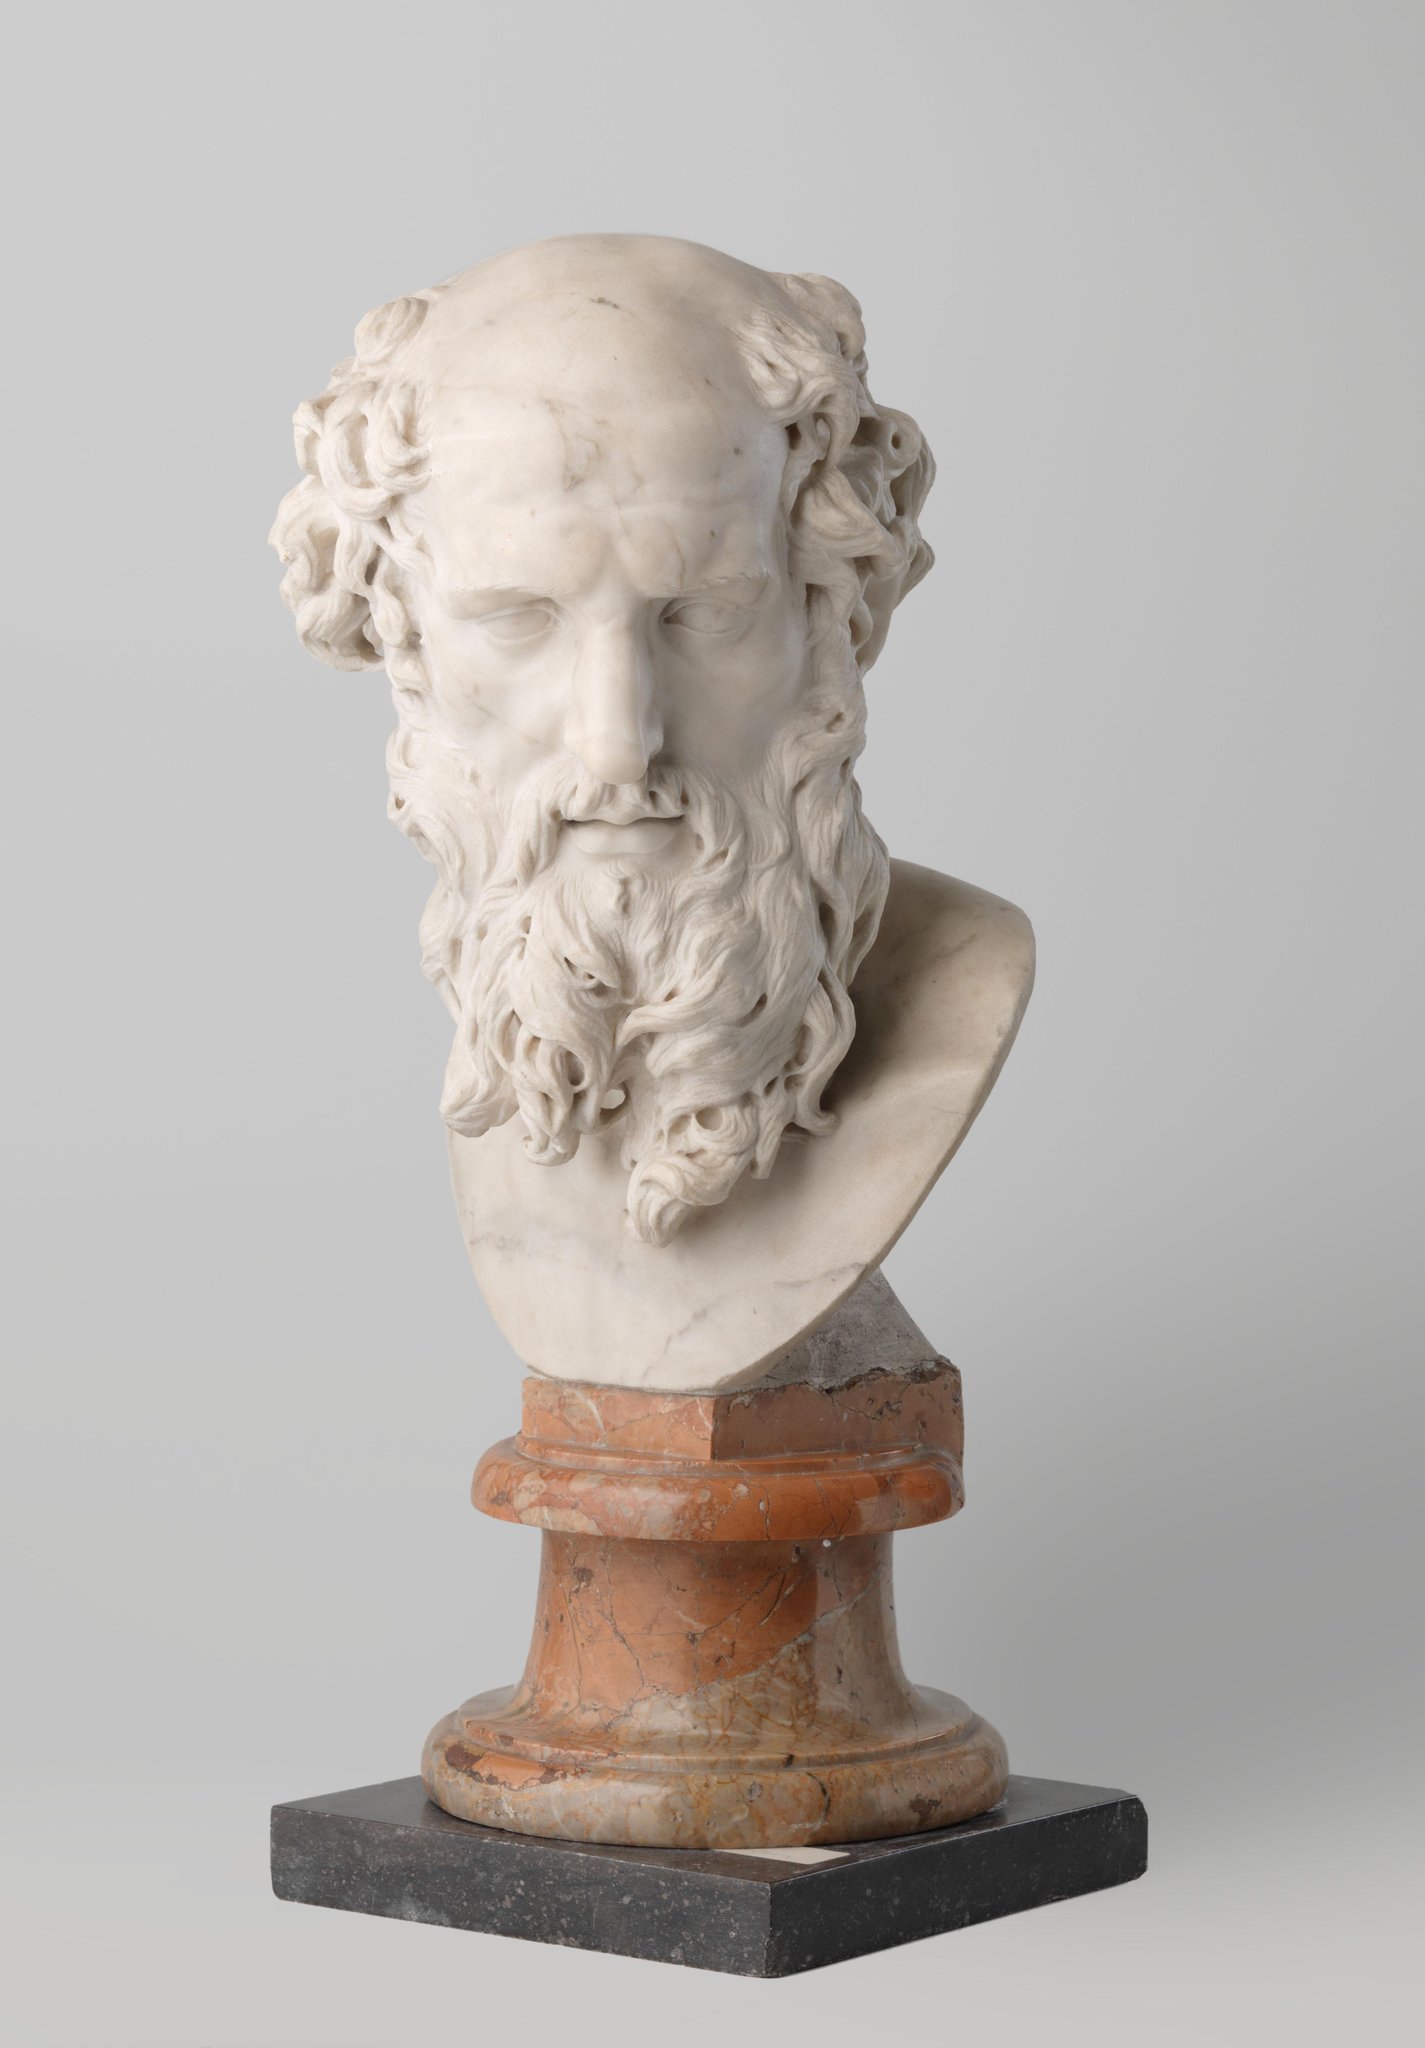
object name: sculpture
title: Plato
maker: orfeo boselli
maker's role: sculptor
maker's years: 1597-1667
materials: marble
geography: rome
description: Orfeo Boselli (c. 1600 - 1667). Two filosophers (Plato and Aristotle?). Marble. Rome, c. 1635 - 1640. On loan from the Koninklijke Bibliotheek, The Hague.